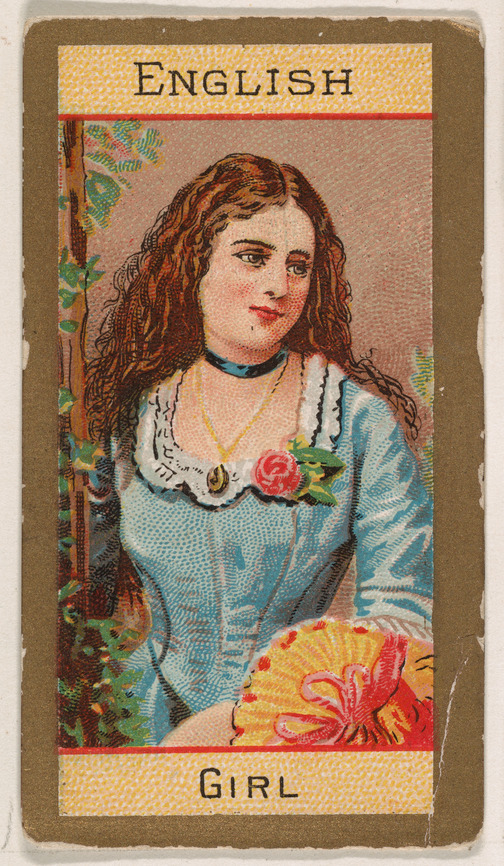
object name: print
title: English Girl, from Types of Nationalities (N240) issued by Kinney Bros.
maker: kinney brothers tobacco company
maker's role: publisher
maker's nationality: american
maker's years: 1869-2011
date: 1890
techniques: color lithograph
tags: girls